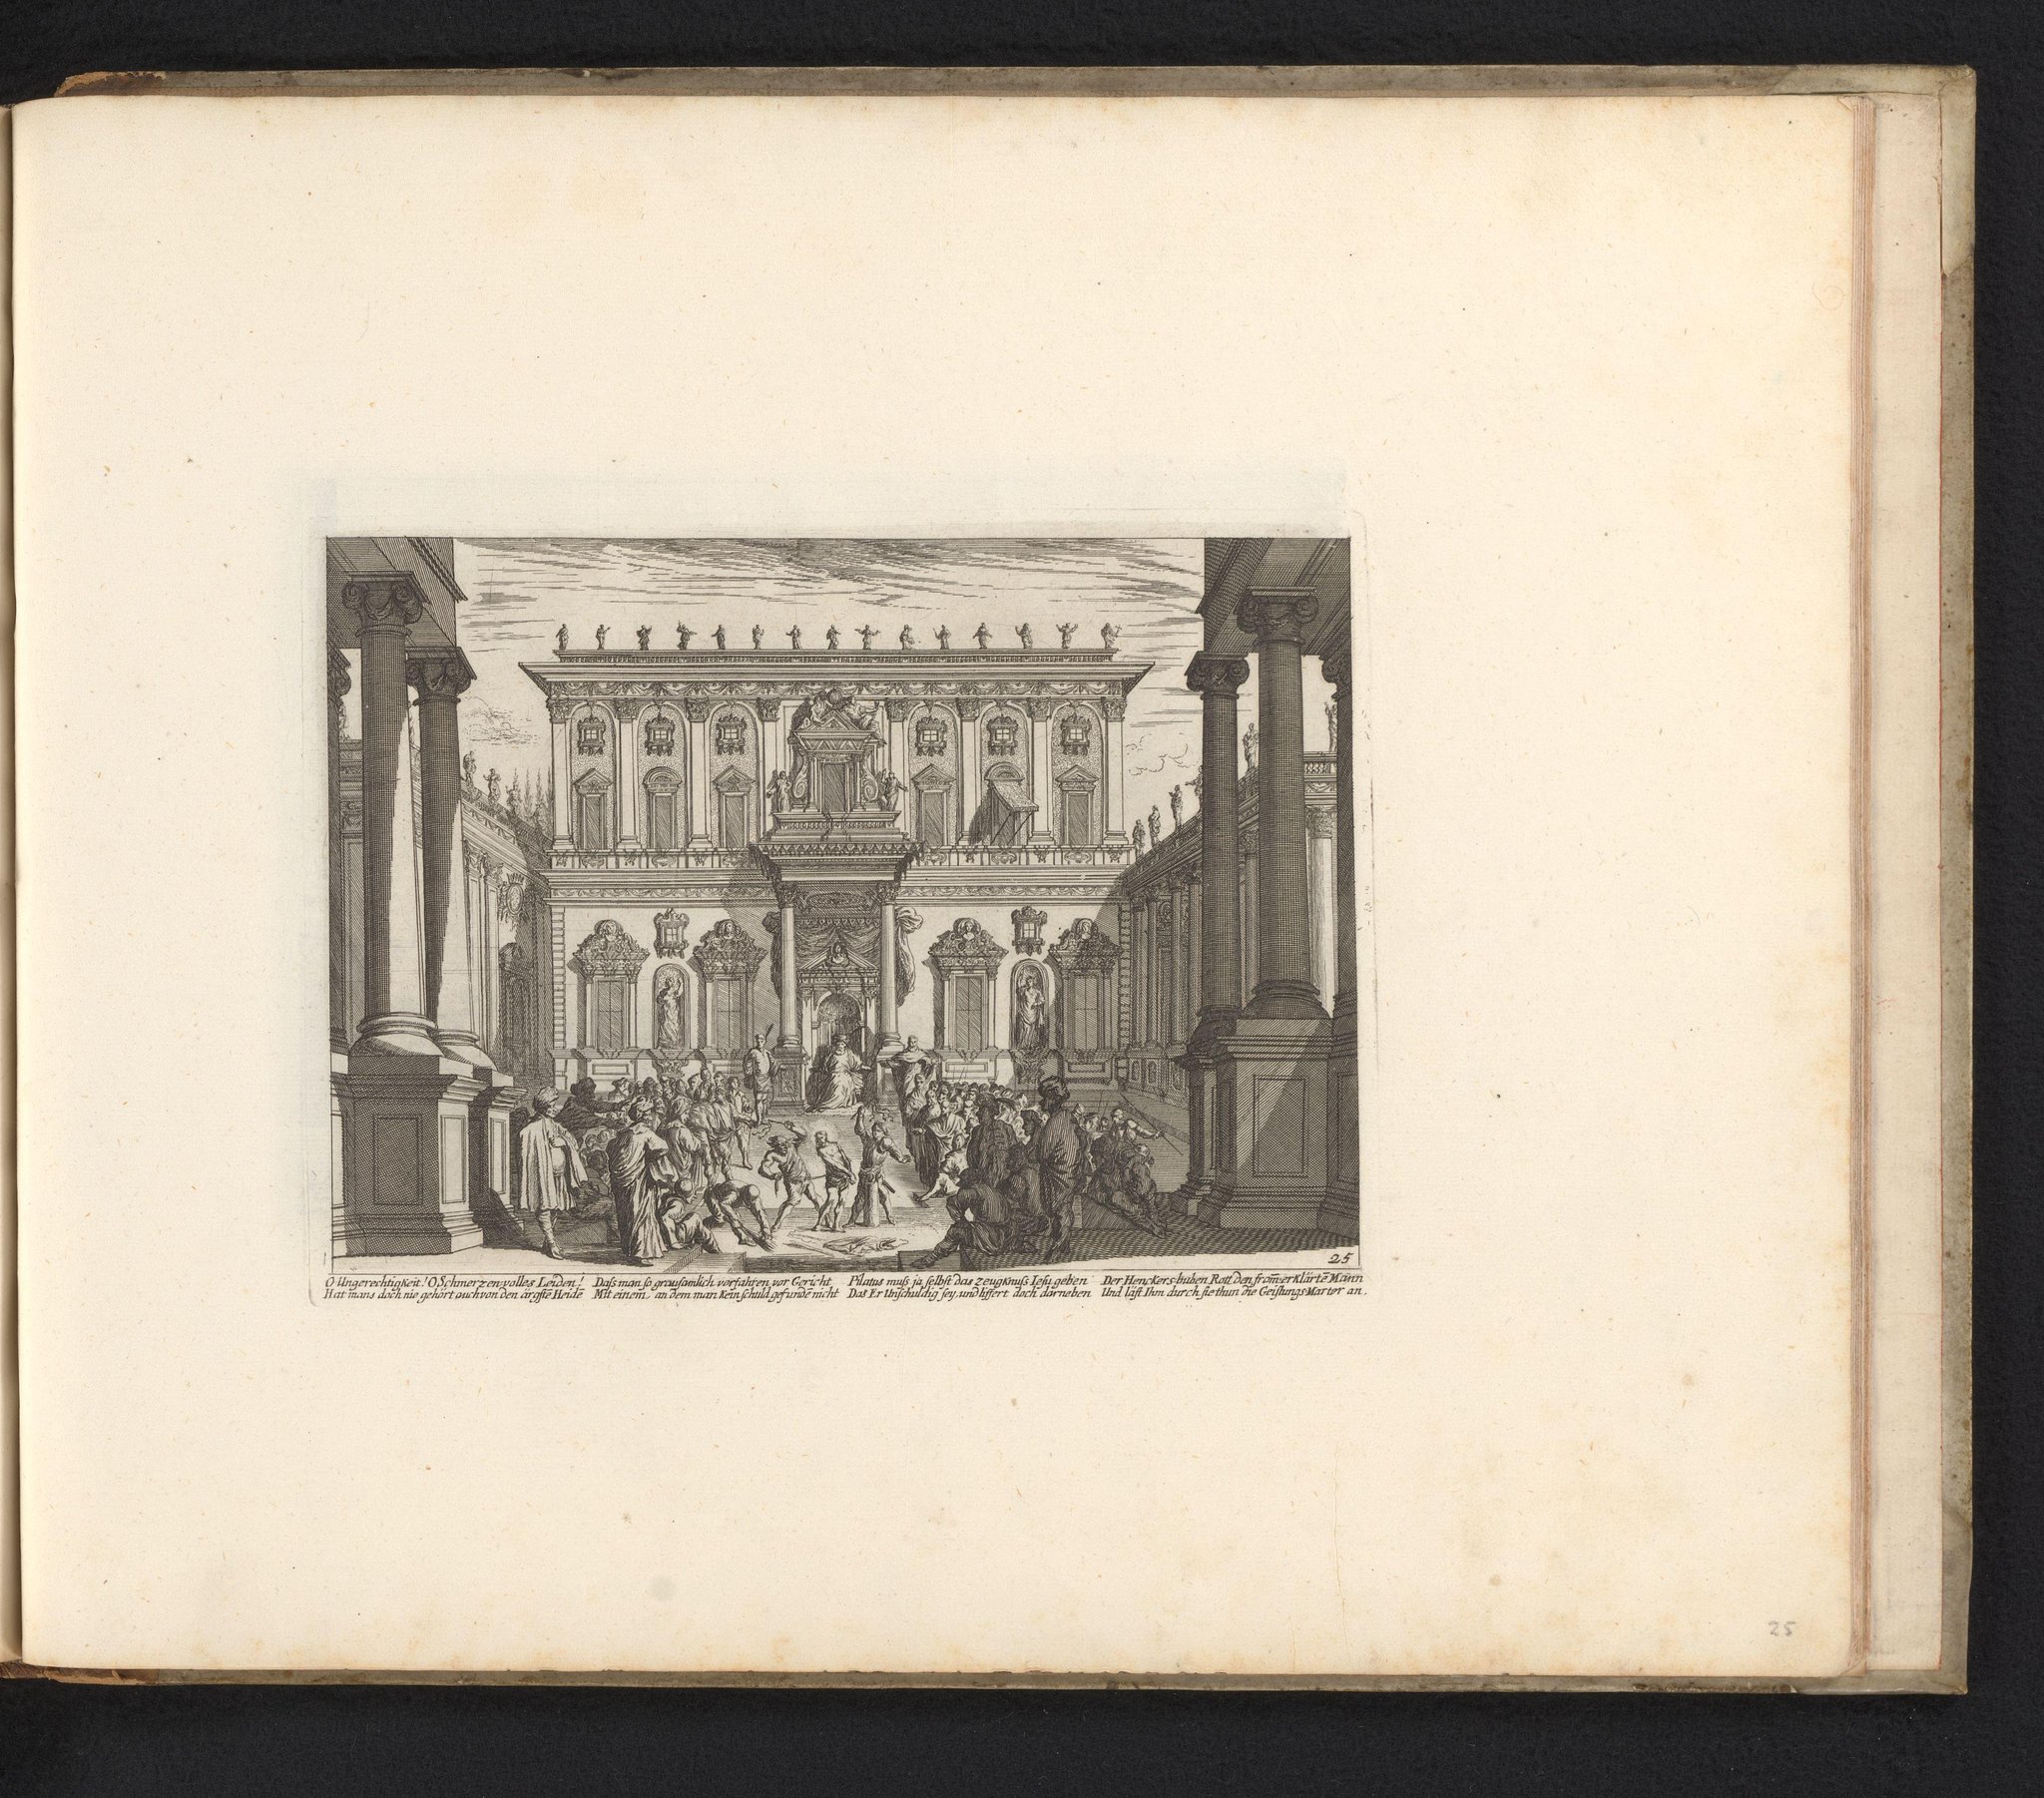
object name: album leaf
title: Geseling van Christus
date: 1670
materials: paper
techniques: etching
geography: augsburg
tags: flagellation by soldiers, christ usually tied to a column (matthew 27:26; mark 15:15; john 19:1)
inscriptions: collector's mark: Lugt 2228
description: Tekst in het Duits in de ondermarge. Rechtsonder genummerd: 25. Prent maakt deel uit van een album.